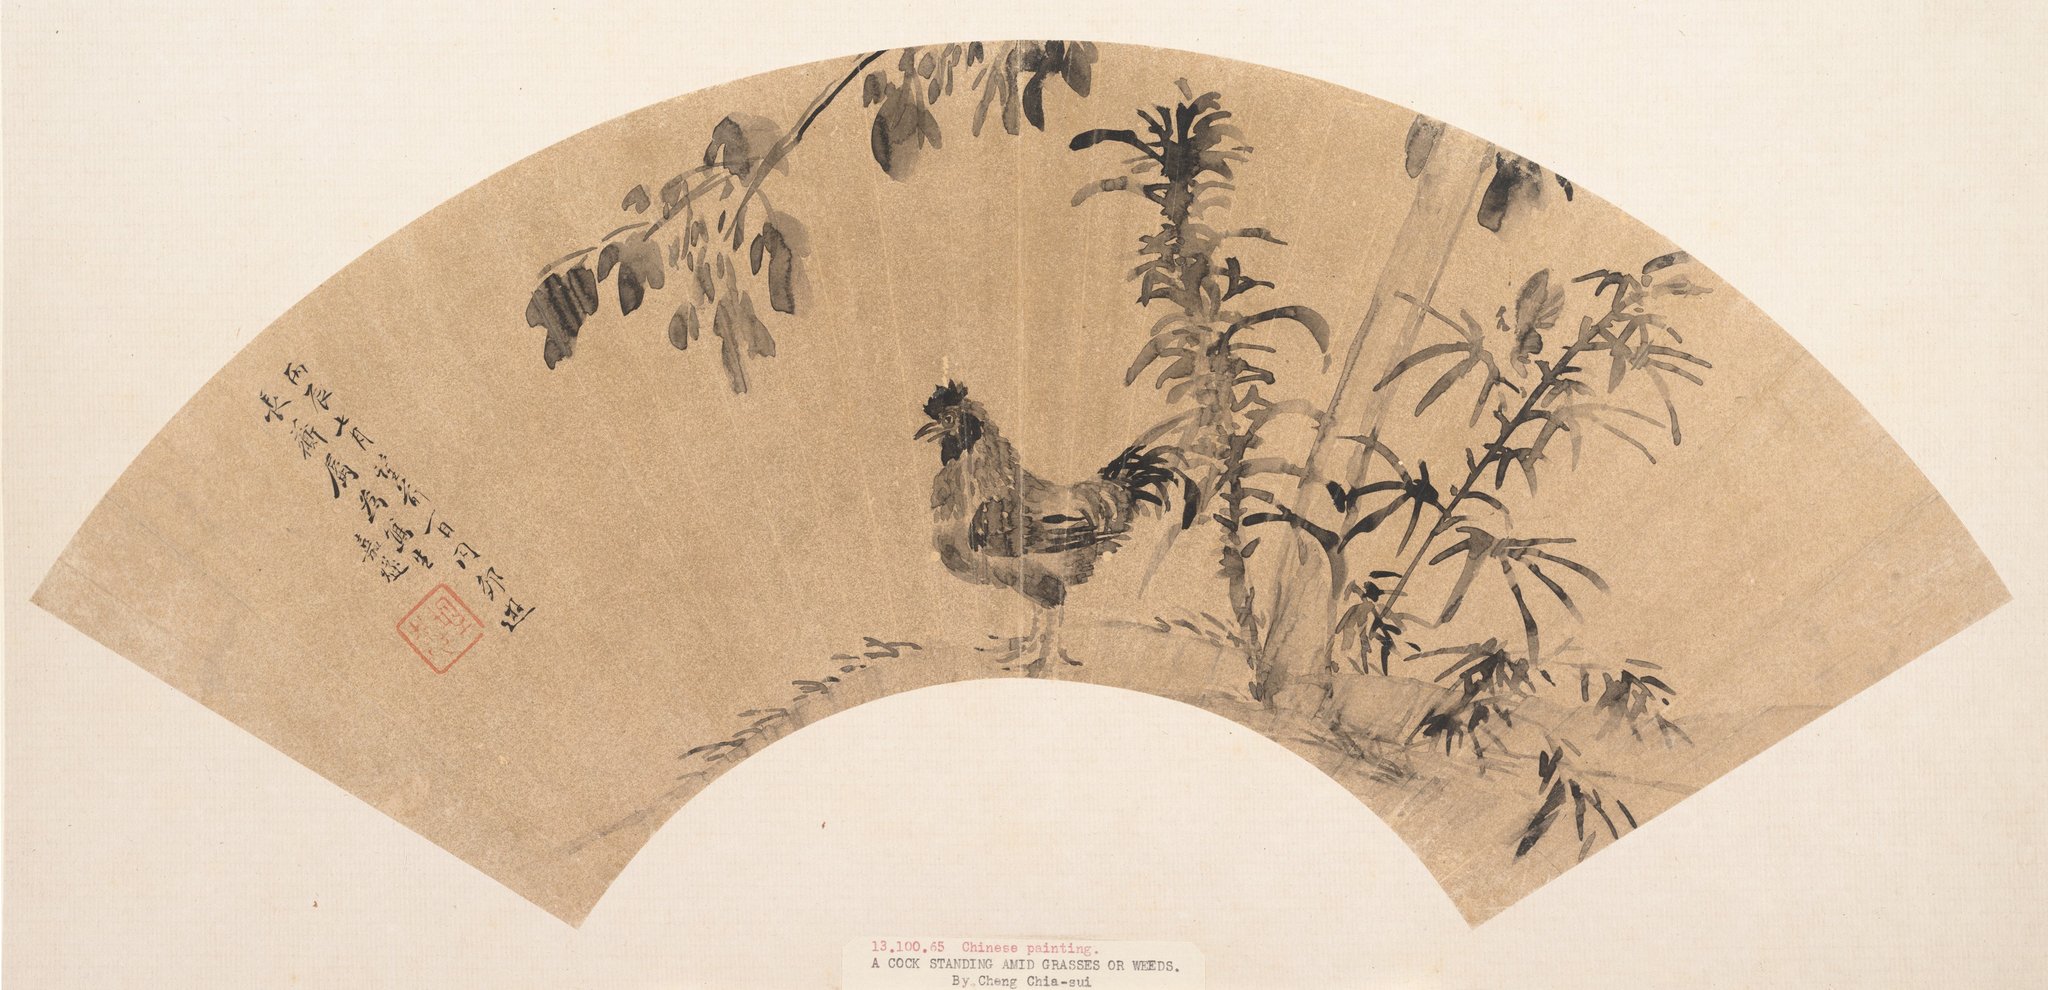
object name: folding fan mounted a an album leaf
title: Landscape with Chicken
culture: chinese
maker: cheng jiasui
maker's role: artist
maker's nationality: chinese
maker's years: 1565-1644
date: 1368-1911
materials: gold, ink, paper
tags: roosters